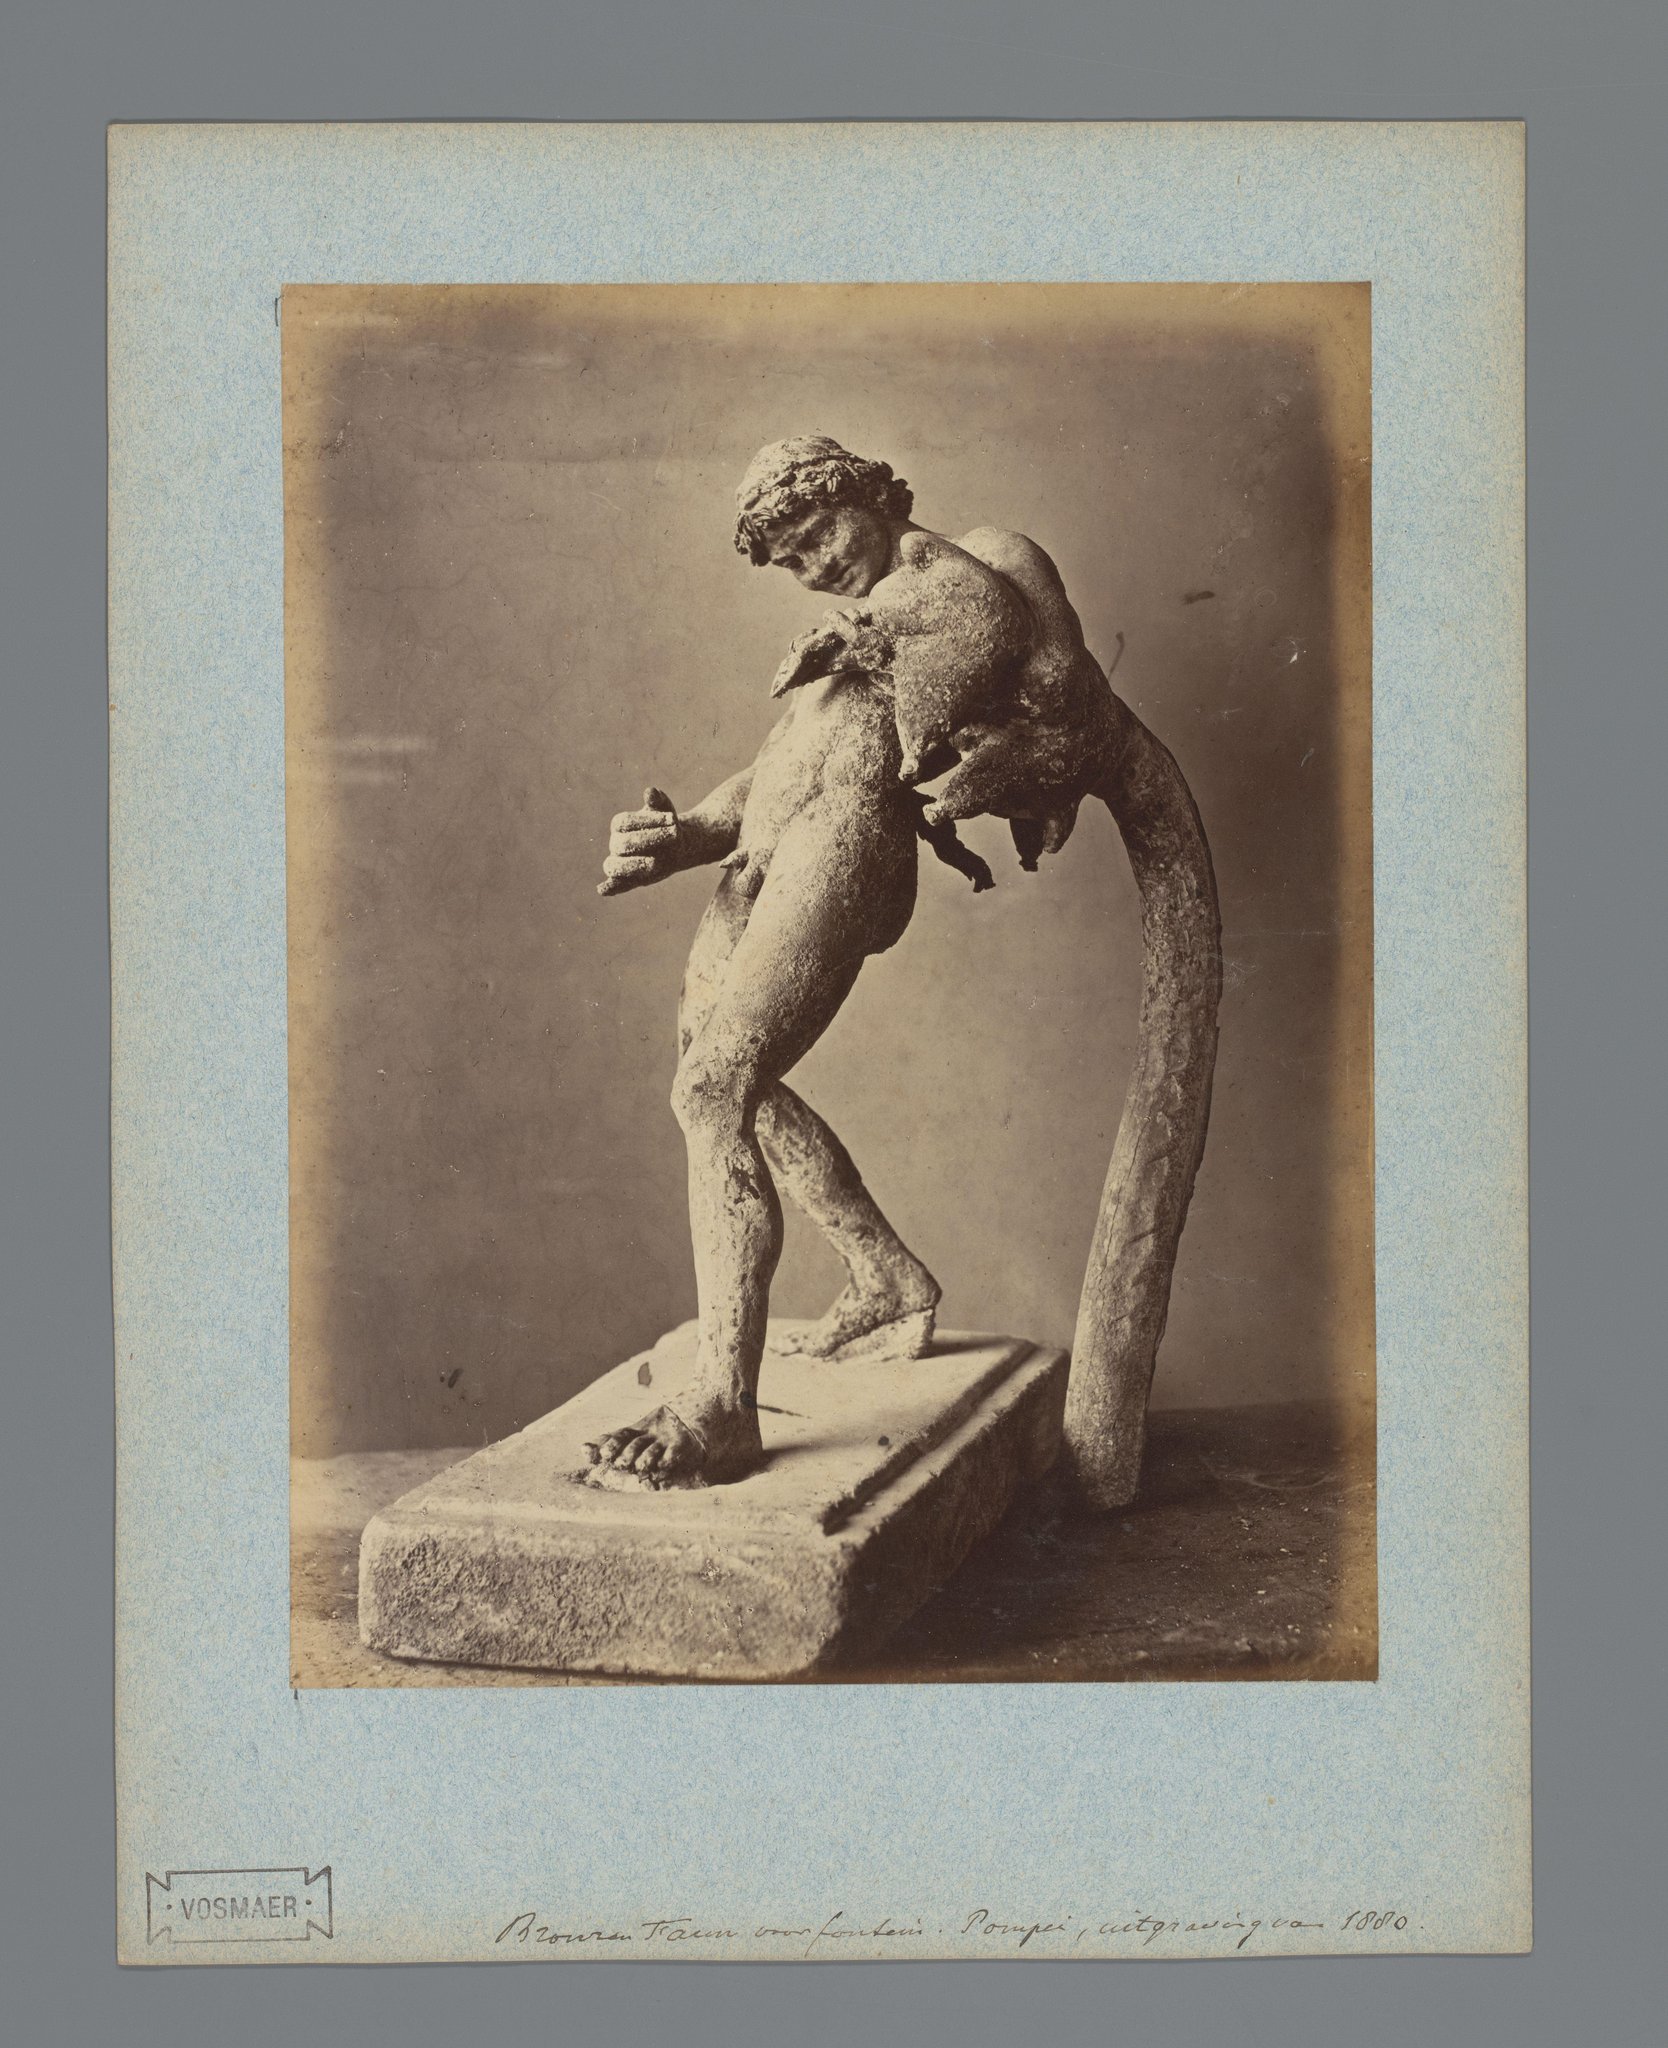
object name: photograph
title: Bronzen faun voor fontein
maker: Anonymous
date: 1880-1890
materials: cardboard, paper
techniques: albumen print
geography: italy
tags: satyrs, fauns, sileni, sculpture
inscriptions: collector's mark: ‘VOSMAER’, inscription: ‘Pompei, uitgravingen van 1880.’